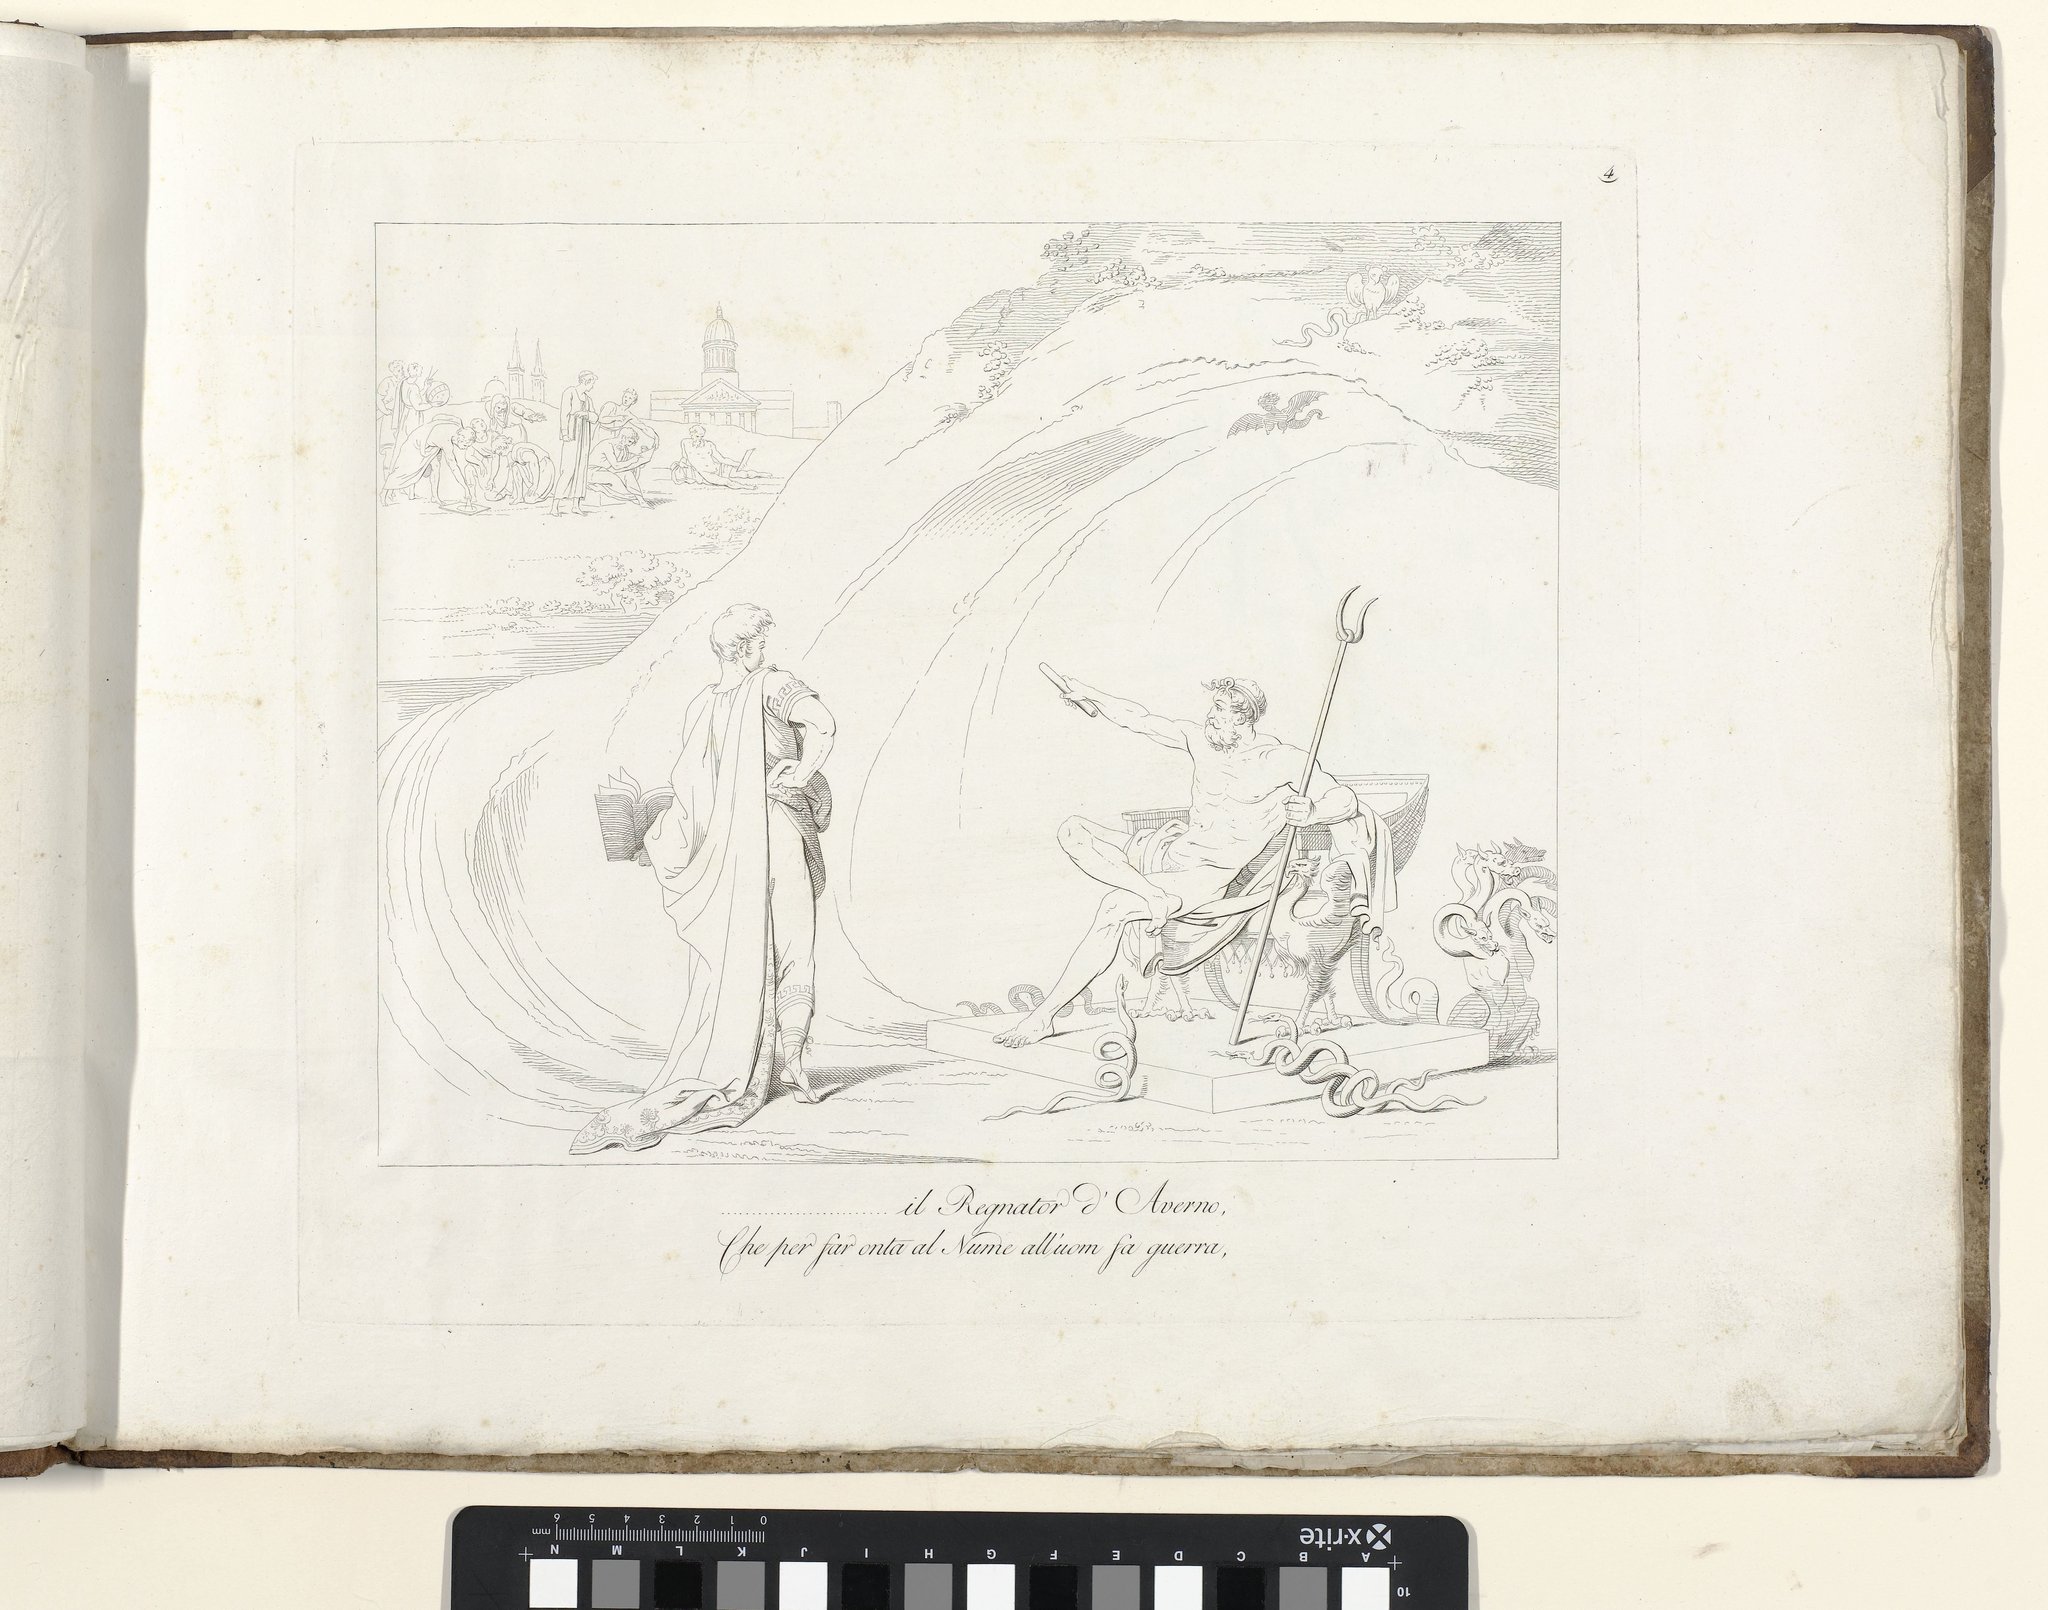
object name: album leaf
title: La pronea del Cesarotti delineata ed incisa dal Matteini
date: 1808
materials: paper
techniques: etching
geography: italy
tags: napoleon i (emperor of the french), (story of) pluto (hades), dis pater, orcus, ruler, sovereign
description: Onder de voorstelling een versregel in het Italiaans. Prent maakt deel uit van een album.